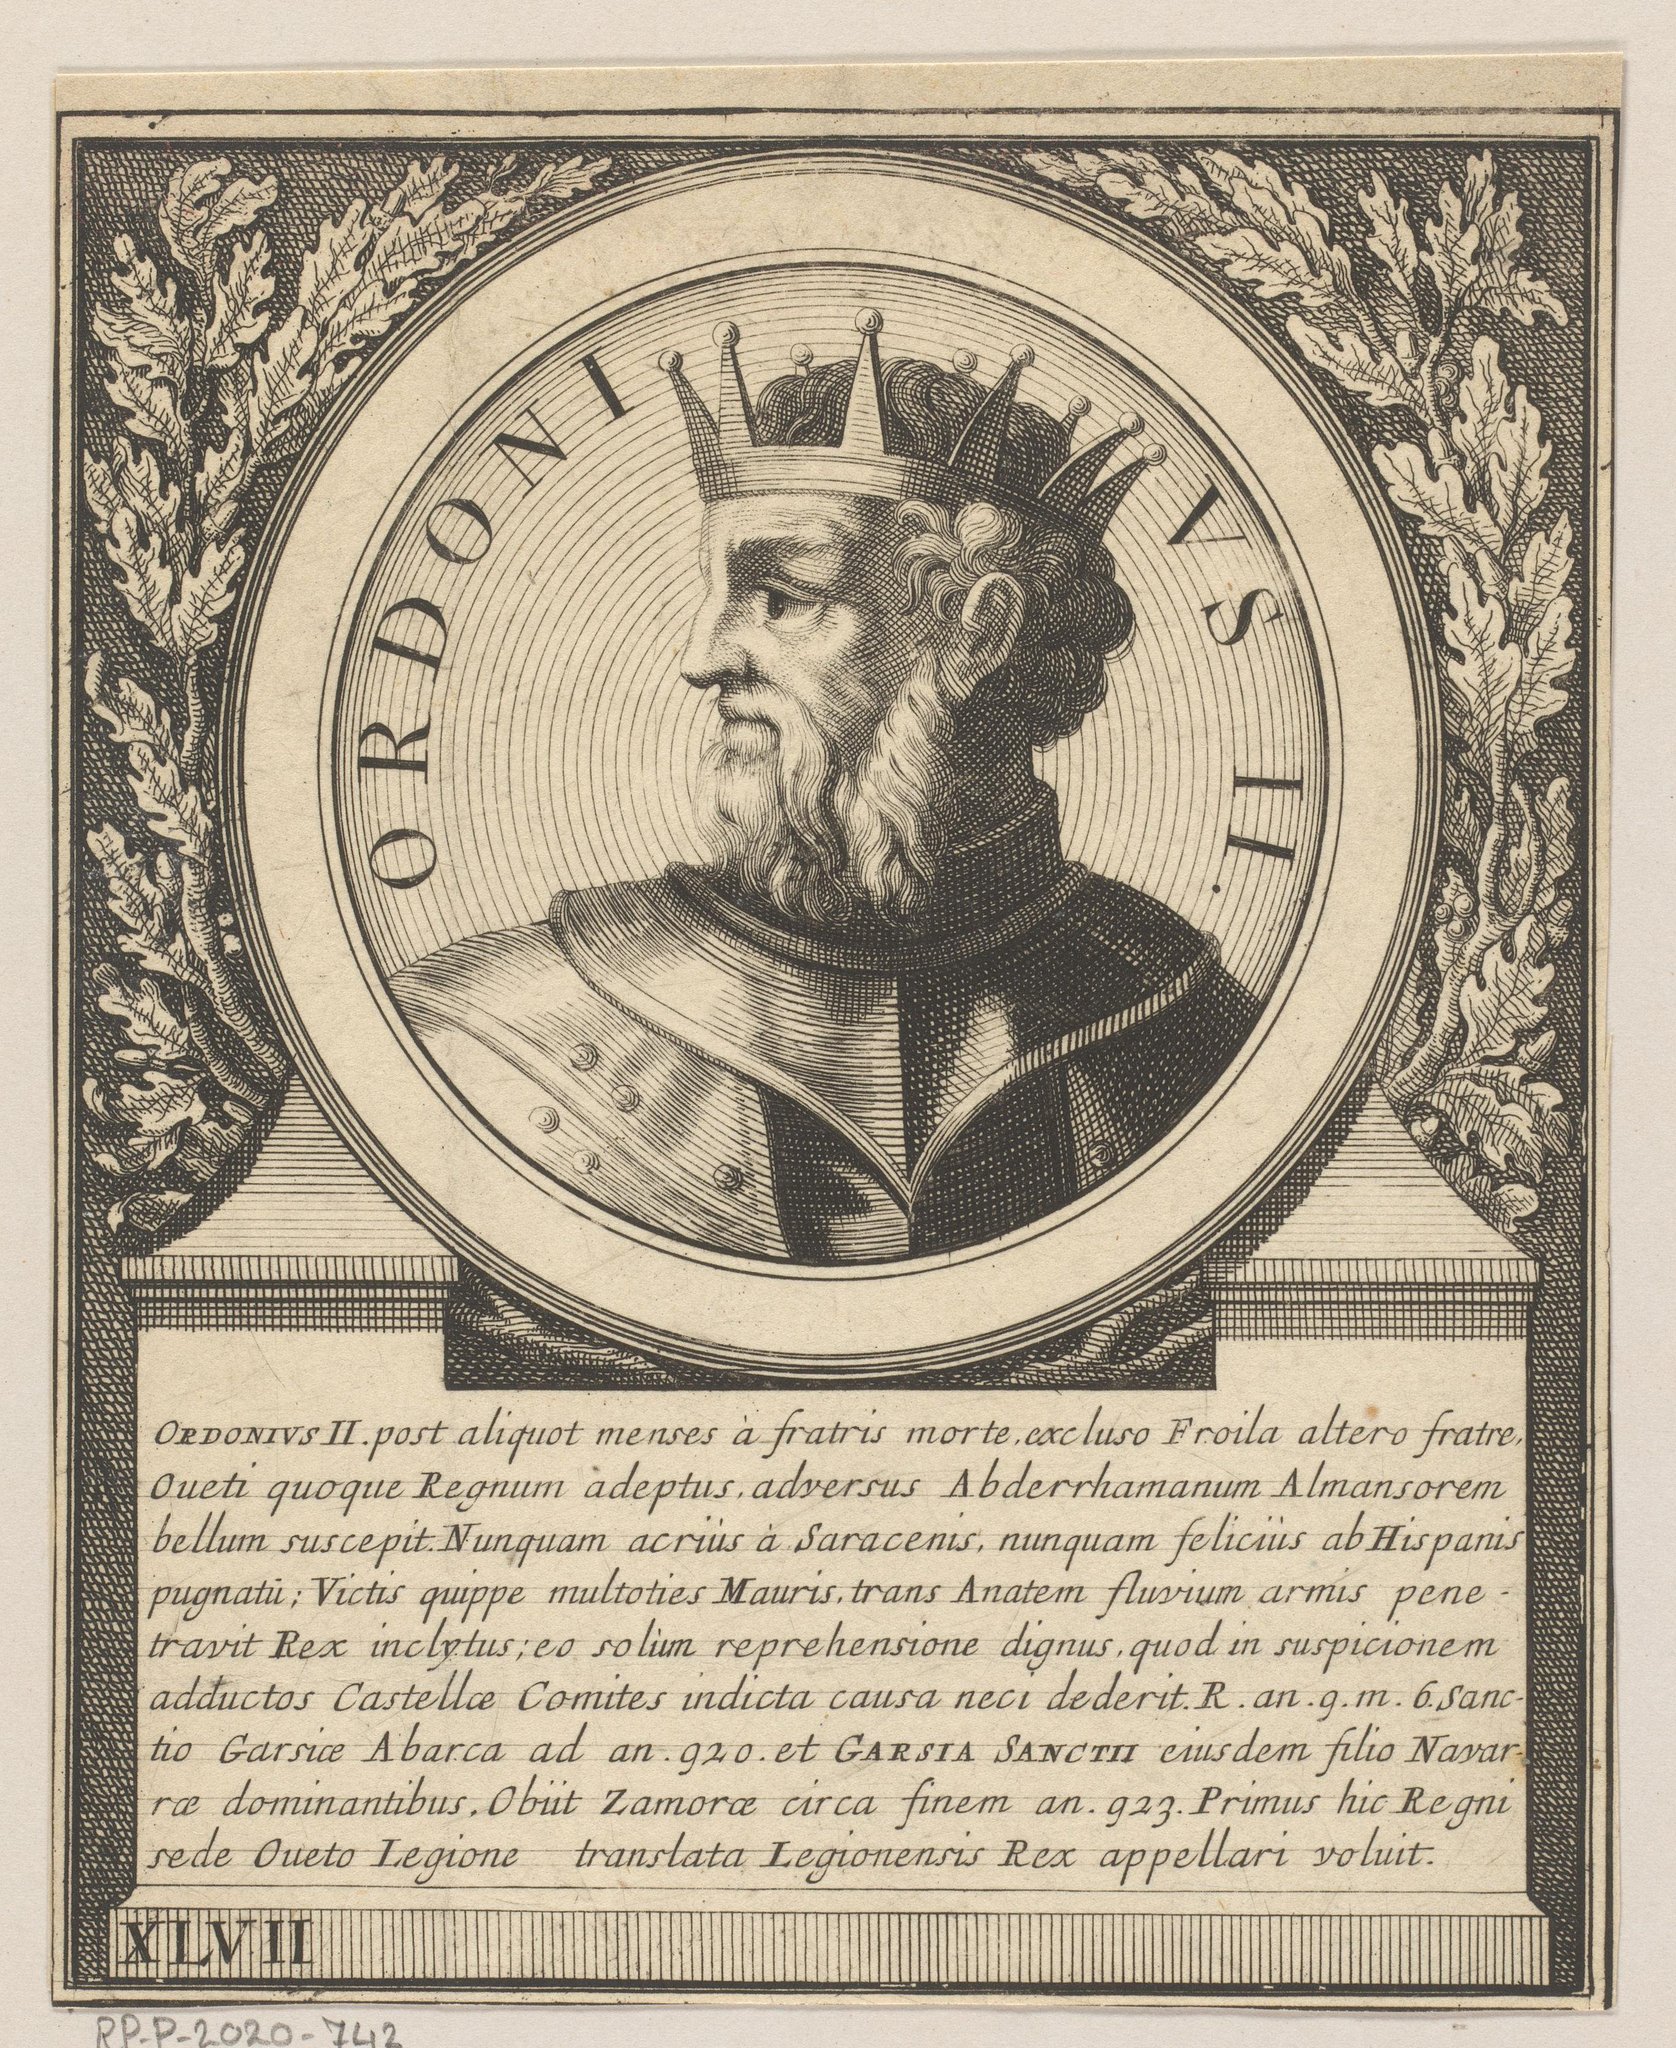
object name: print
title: Ordonius II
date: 1698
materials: paper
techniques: engraving, etching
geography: paris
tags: historical persons, ruler, sovereign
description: Portret afkomstig van een grote prent, getiteld 'Series Chronologica et Imagines Regum Hispaniae ab Ataulpho ad Carolum II', bestaande uit meerdere bladen die samengevoegd konden worden, uitgegeven door Petrus de la Tour in 1698.